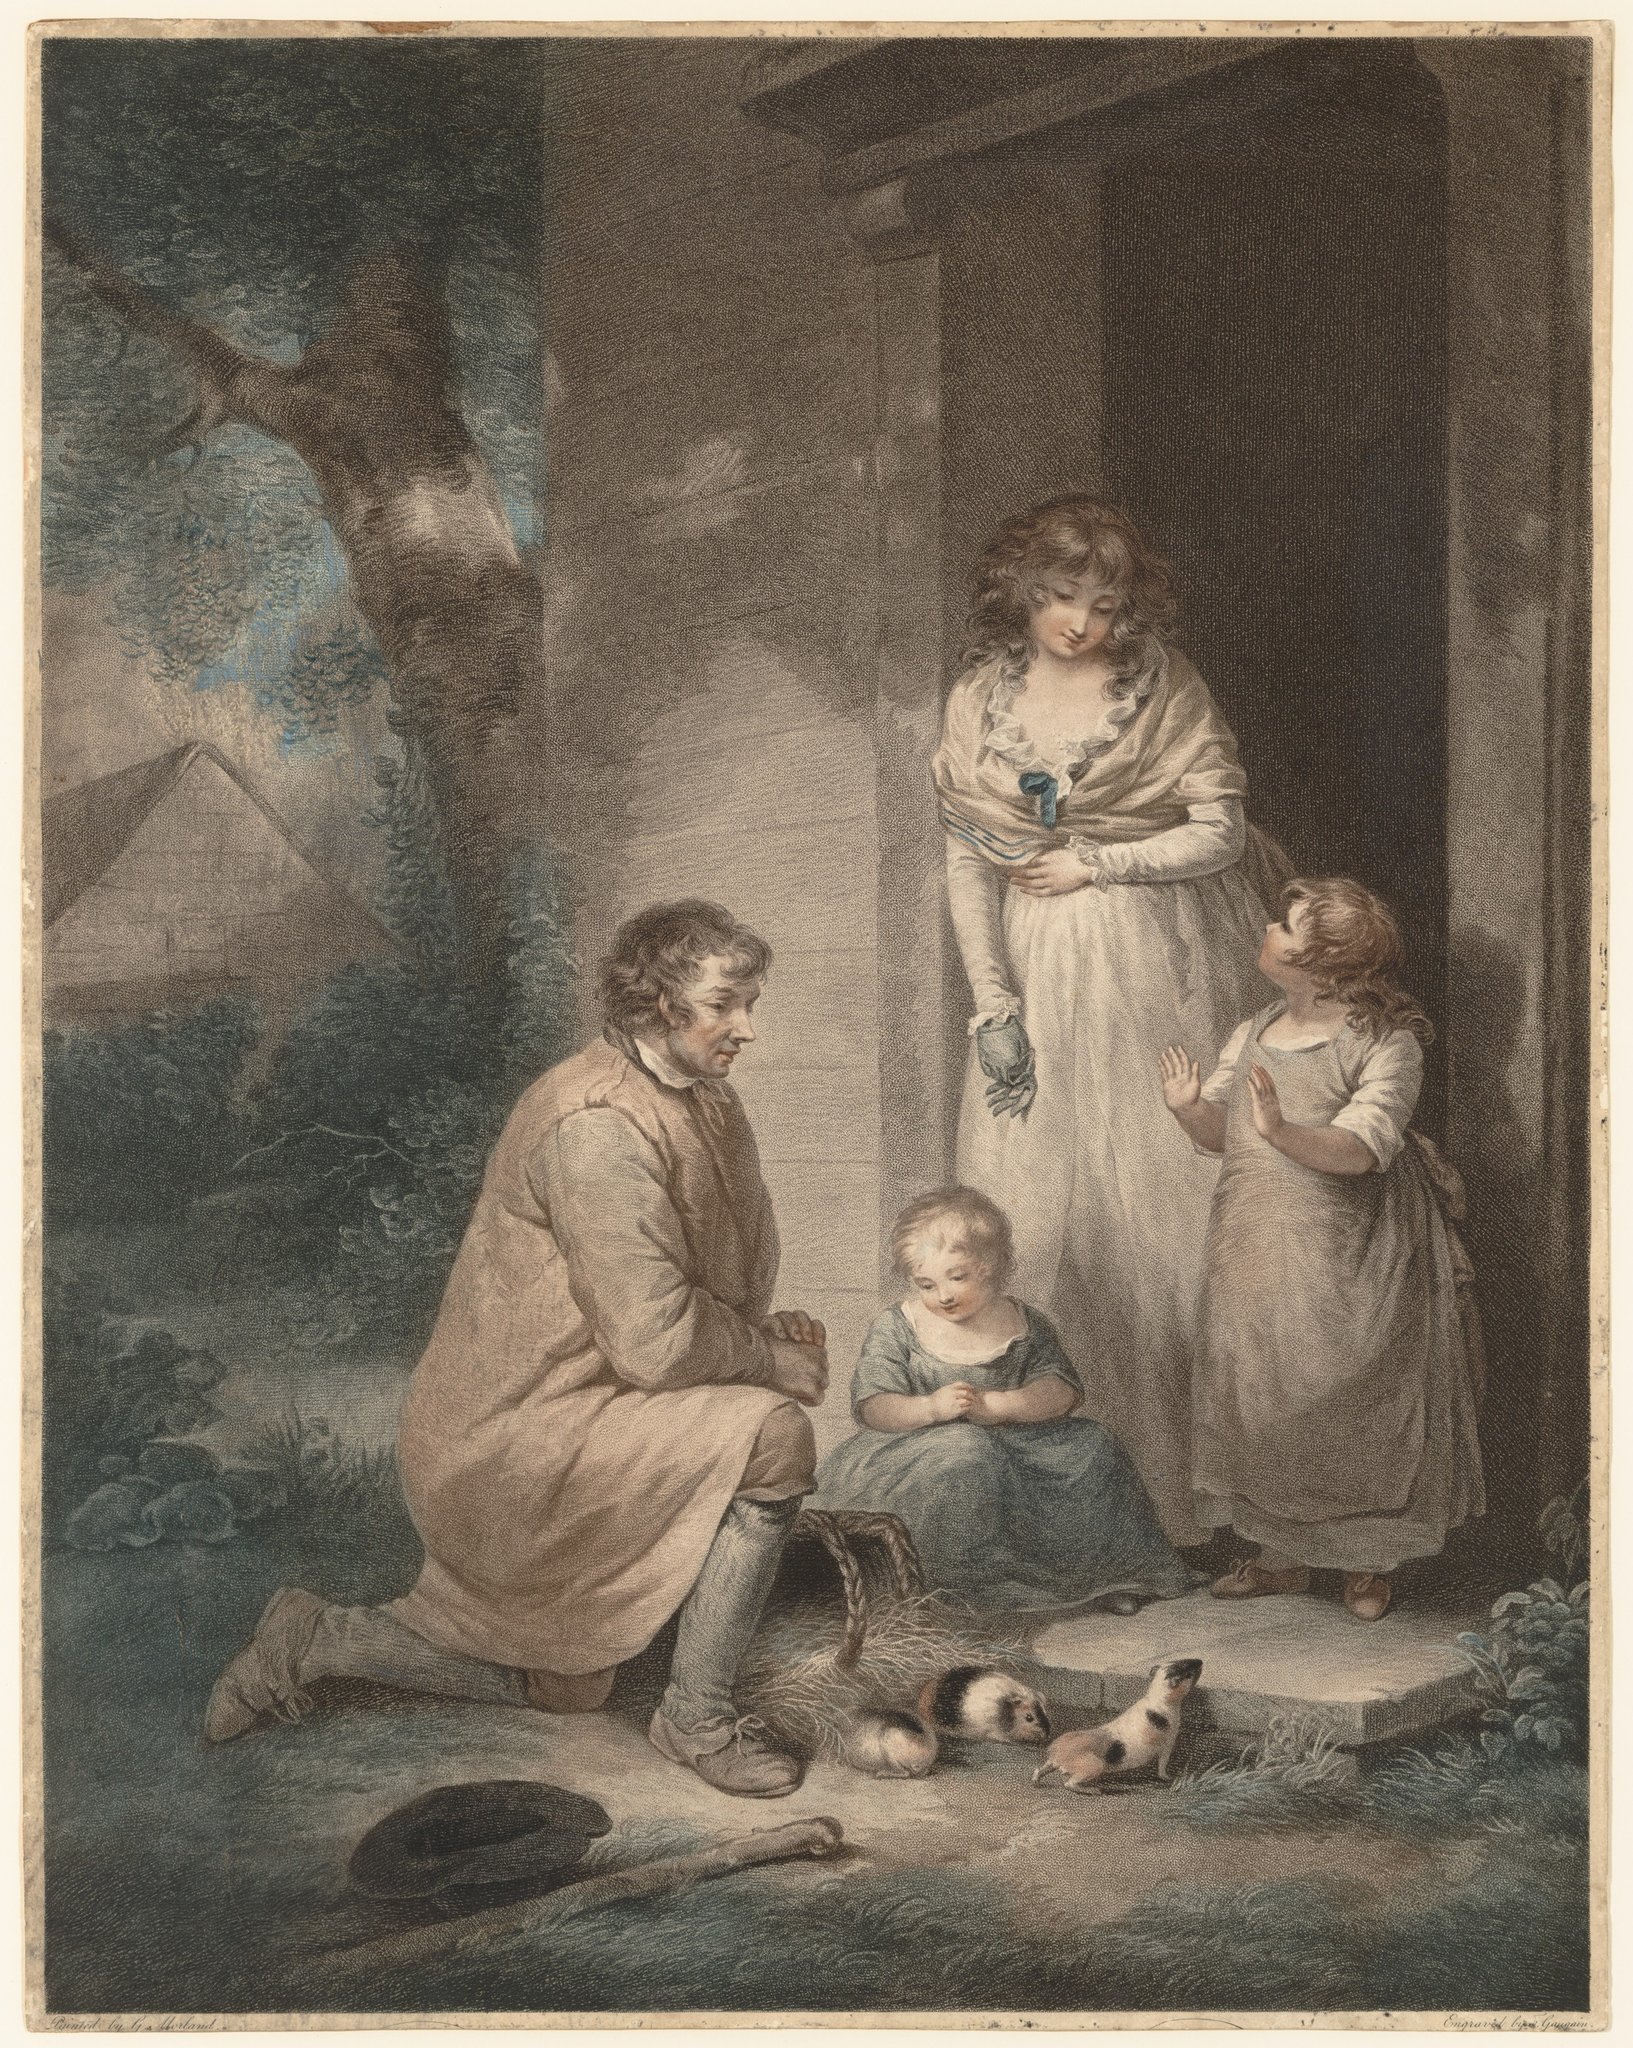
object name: print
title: Guinea Pigs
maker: thomas gaugain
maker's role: artist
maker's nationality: british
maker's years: 1756-1810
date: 1789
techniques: etching, printing, engraving, lithography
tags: girls,men,women,pigs,family